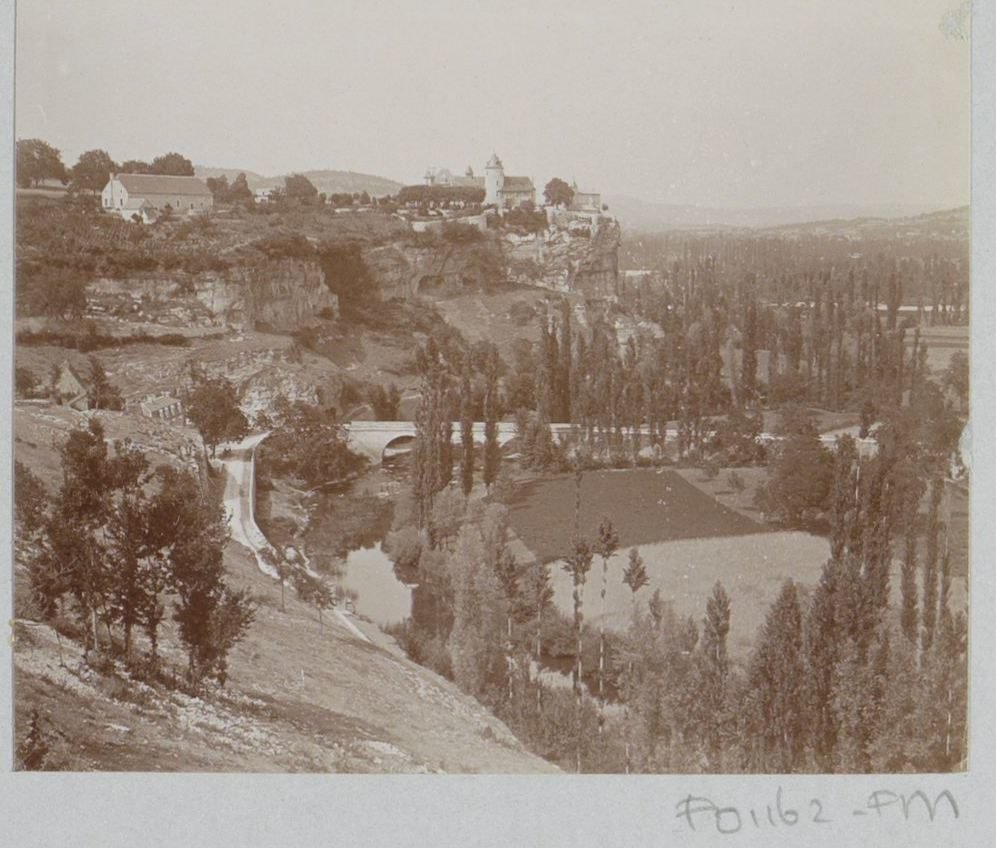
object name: photograph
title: Landschap met een stad op rotsen en een vallei met een rivier in Frankrijk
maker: Anonymous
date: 1905-1910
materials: paper, photographic support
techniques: gelatin silver print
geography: france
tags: landscape with bridge, viaduct or aqueduct, prospect of city, town panorama, silhouette of city, france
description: Onderdeel van Fotoalbum van een Franse amateurfotograaf met bezienswaardigheden in Frankrijk, Zwitserland en Italië.